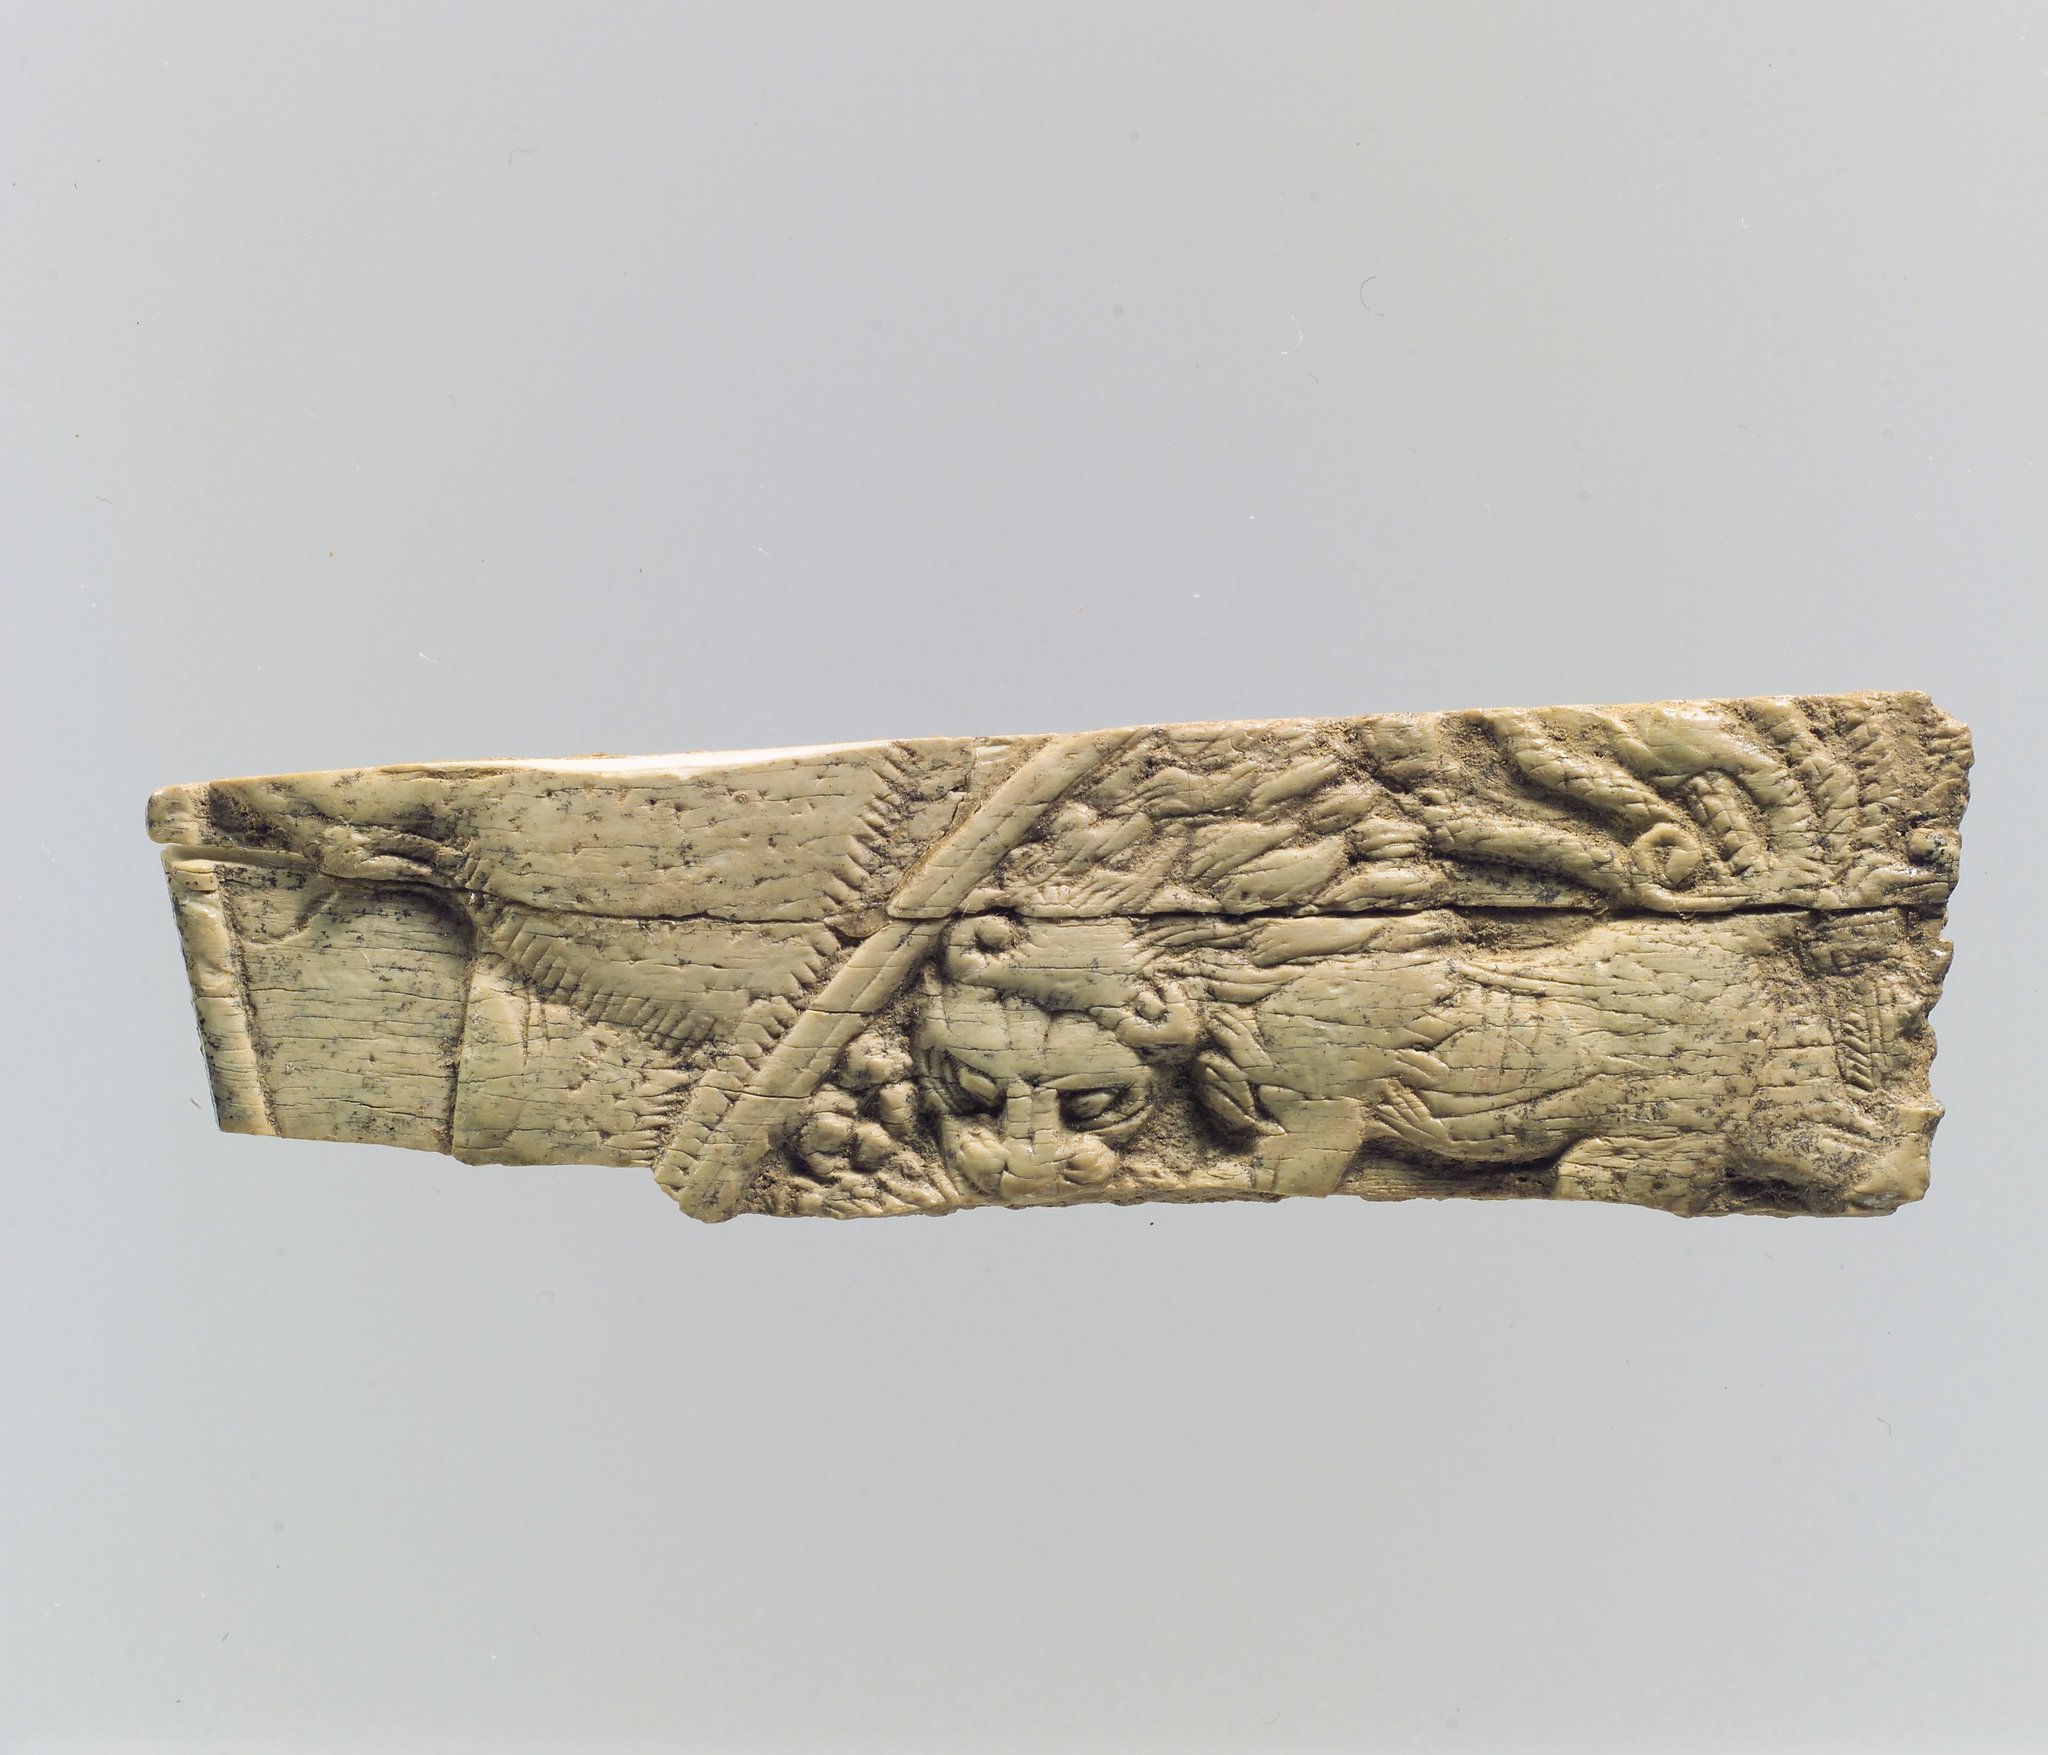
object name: relief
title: Panel fragment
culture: iranian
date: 800-601 BCE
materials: ivory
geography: iran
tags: lions